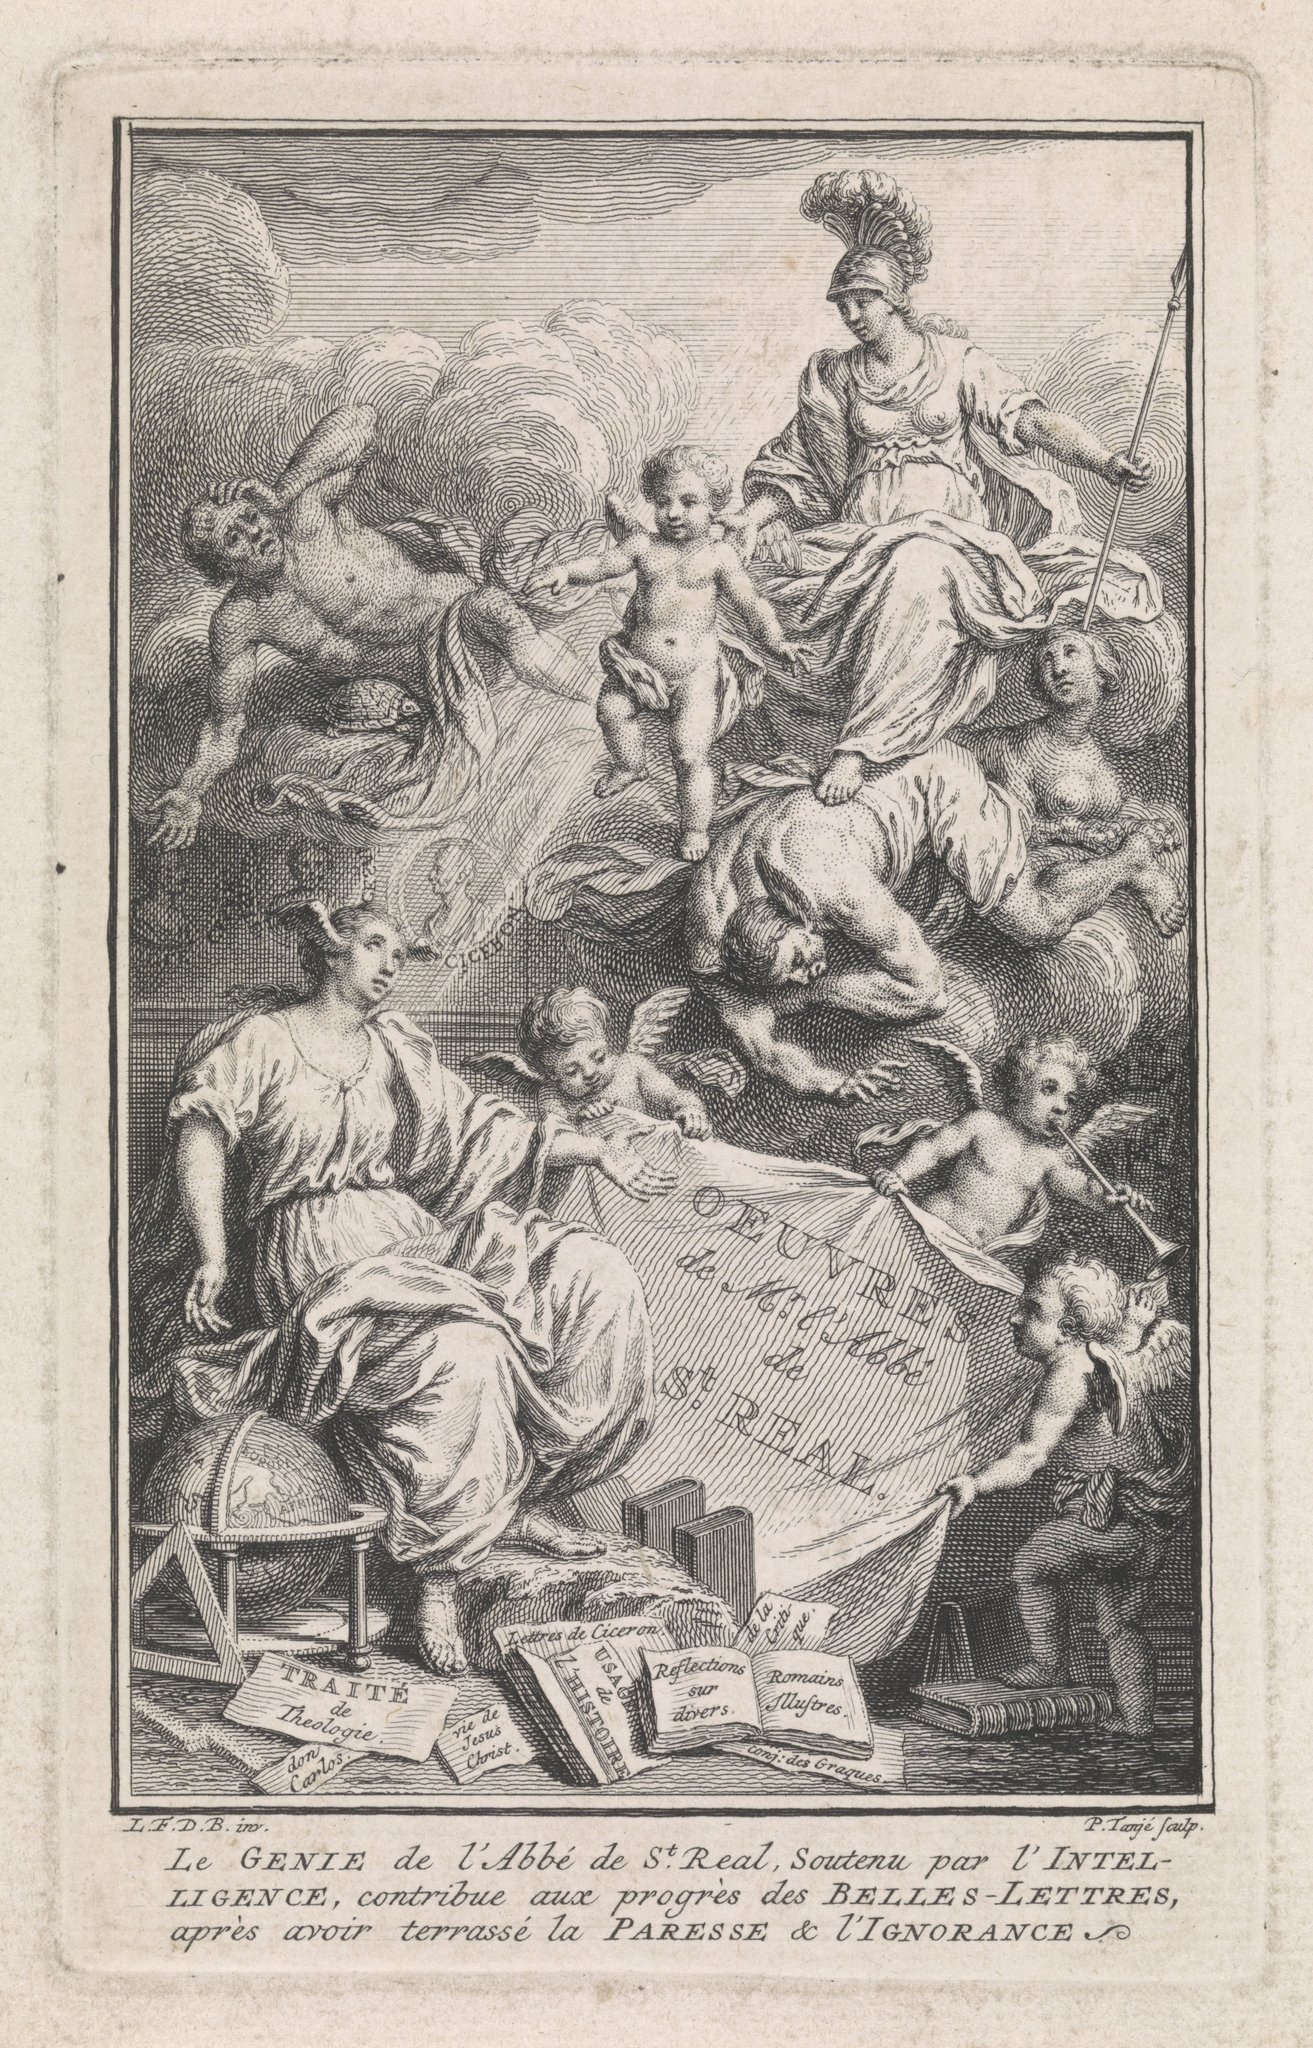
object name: titelblad, titelpagina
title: Minerva overwint de onwetendheid en de luiheid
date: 1716-1761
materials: paper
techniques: engraving, etching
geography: amsterdam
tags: minerva as patroness, sloth, indolence, 'acedia', 'desidia'; 'accidia' (ripa) ~ personification of one of the seven deadly sins, ignorance; 'ignoranza', 'ignoranza di tutte le cose', 'ignoranza in un ricco senza lettere' (ripa), 'genio' (ripa)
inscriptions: collector's mark: Lugt 2228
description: Minerva, gezeten op de wolken, heeft de Onwetendheid onder haar voeten en de luiheid, met een schildpad, vlucht van haar. Bij een globe en bij de titels van schrijver César Vichard de Saint Réal zit het Genie.